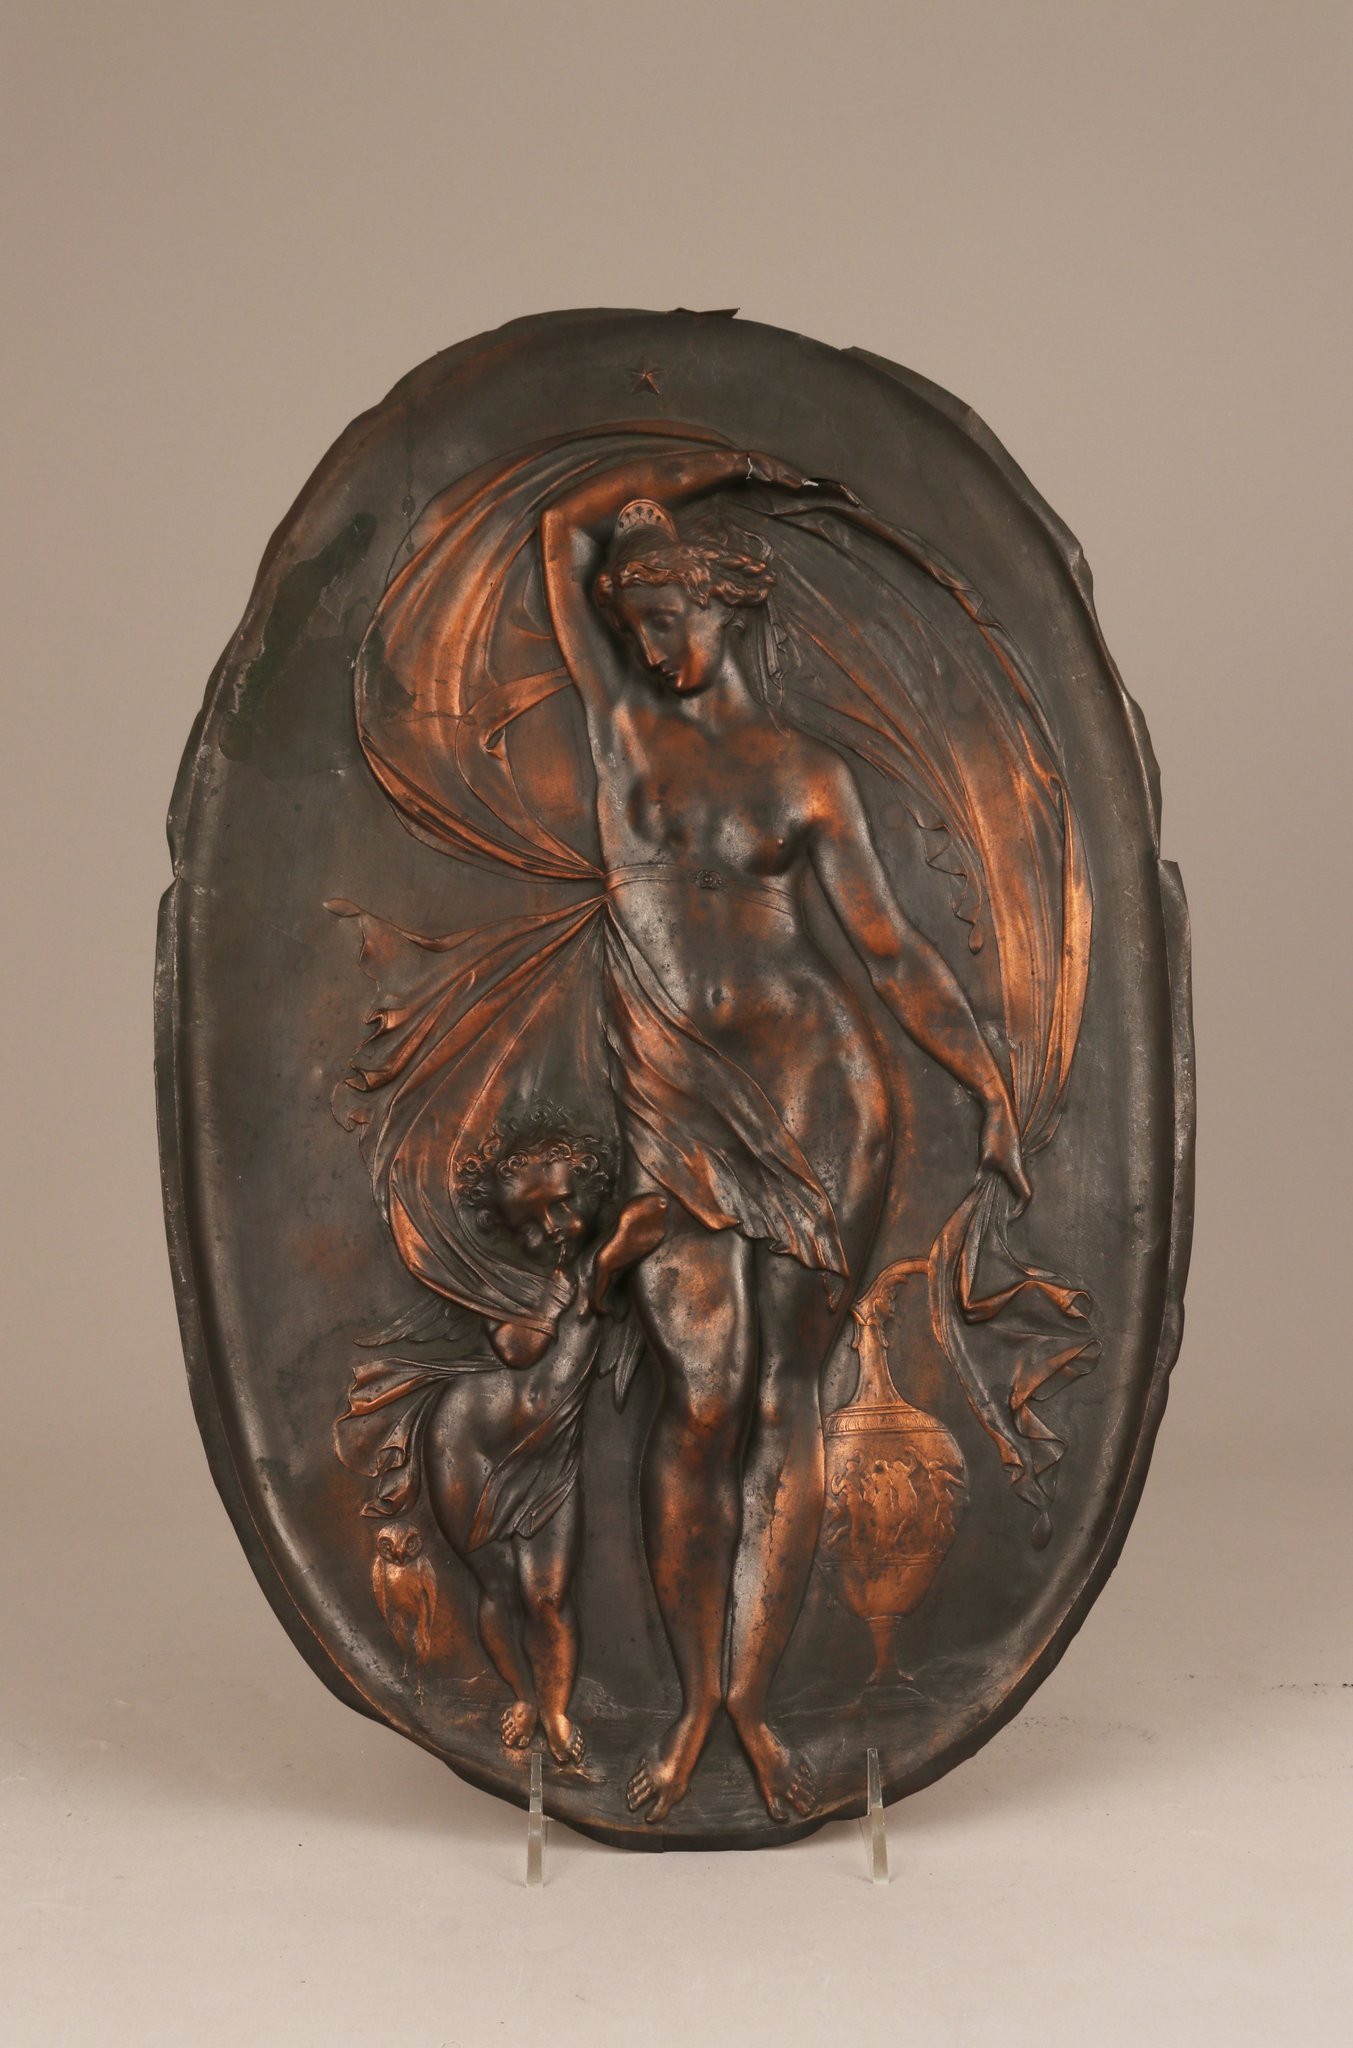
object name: medallion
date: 1801-1900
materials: copper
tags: children,female nudes,owls